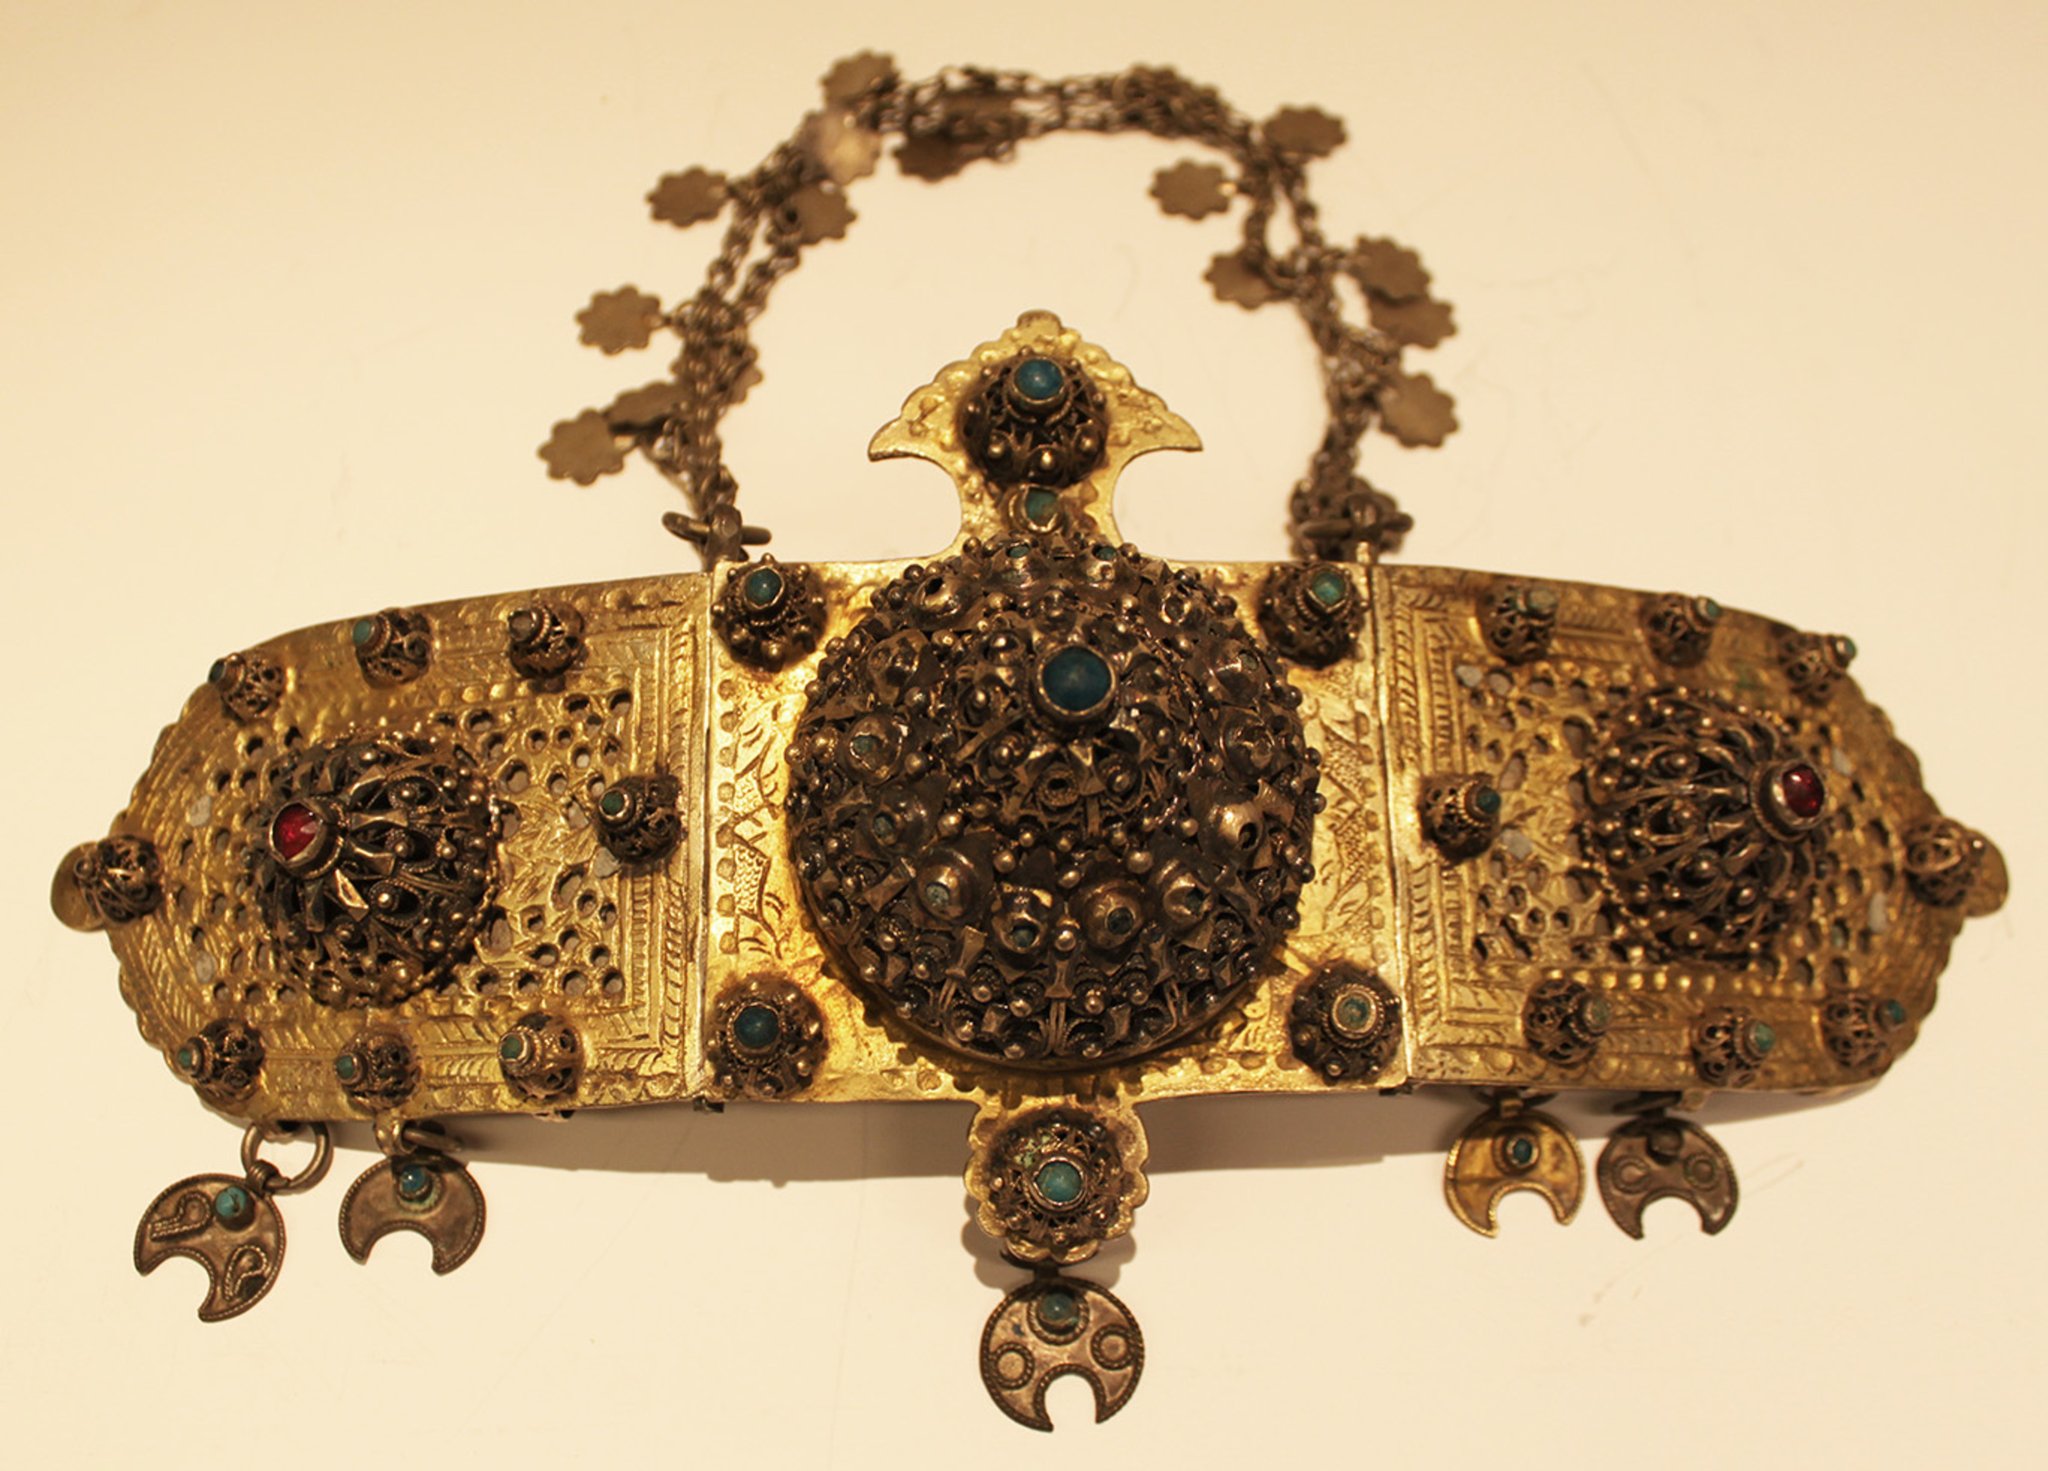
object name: girdle clasp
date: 1801-1900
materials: brass, silver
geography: turkey